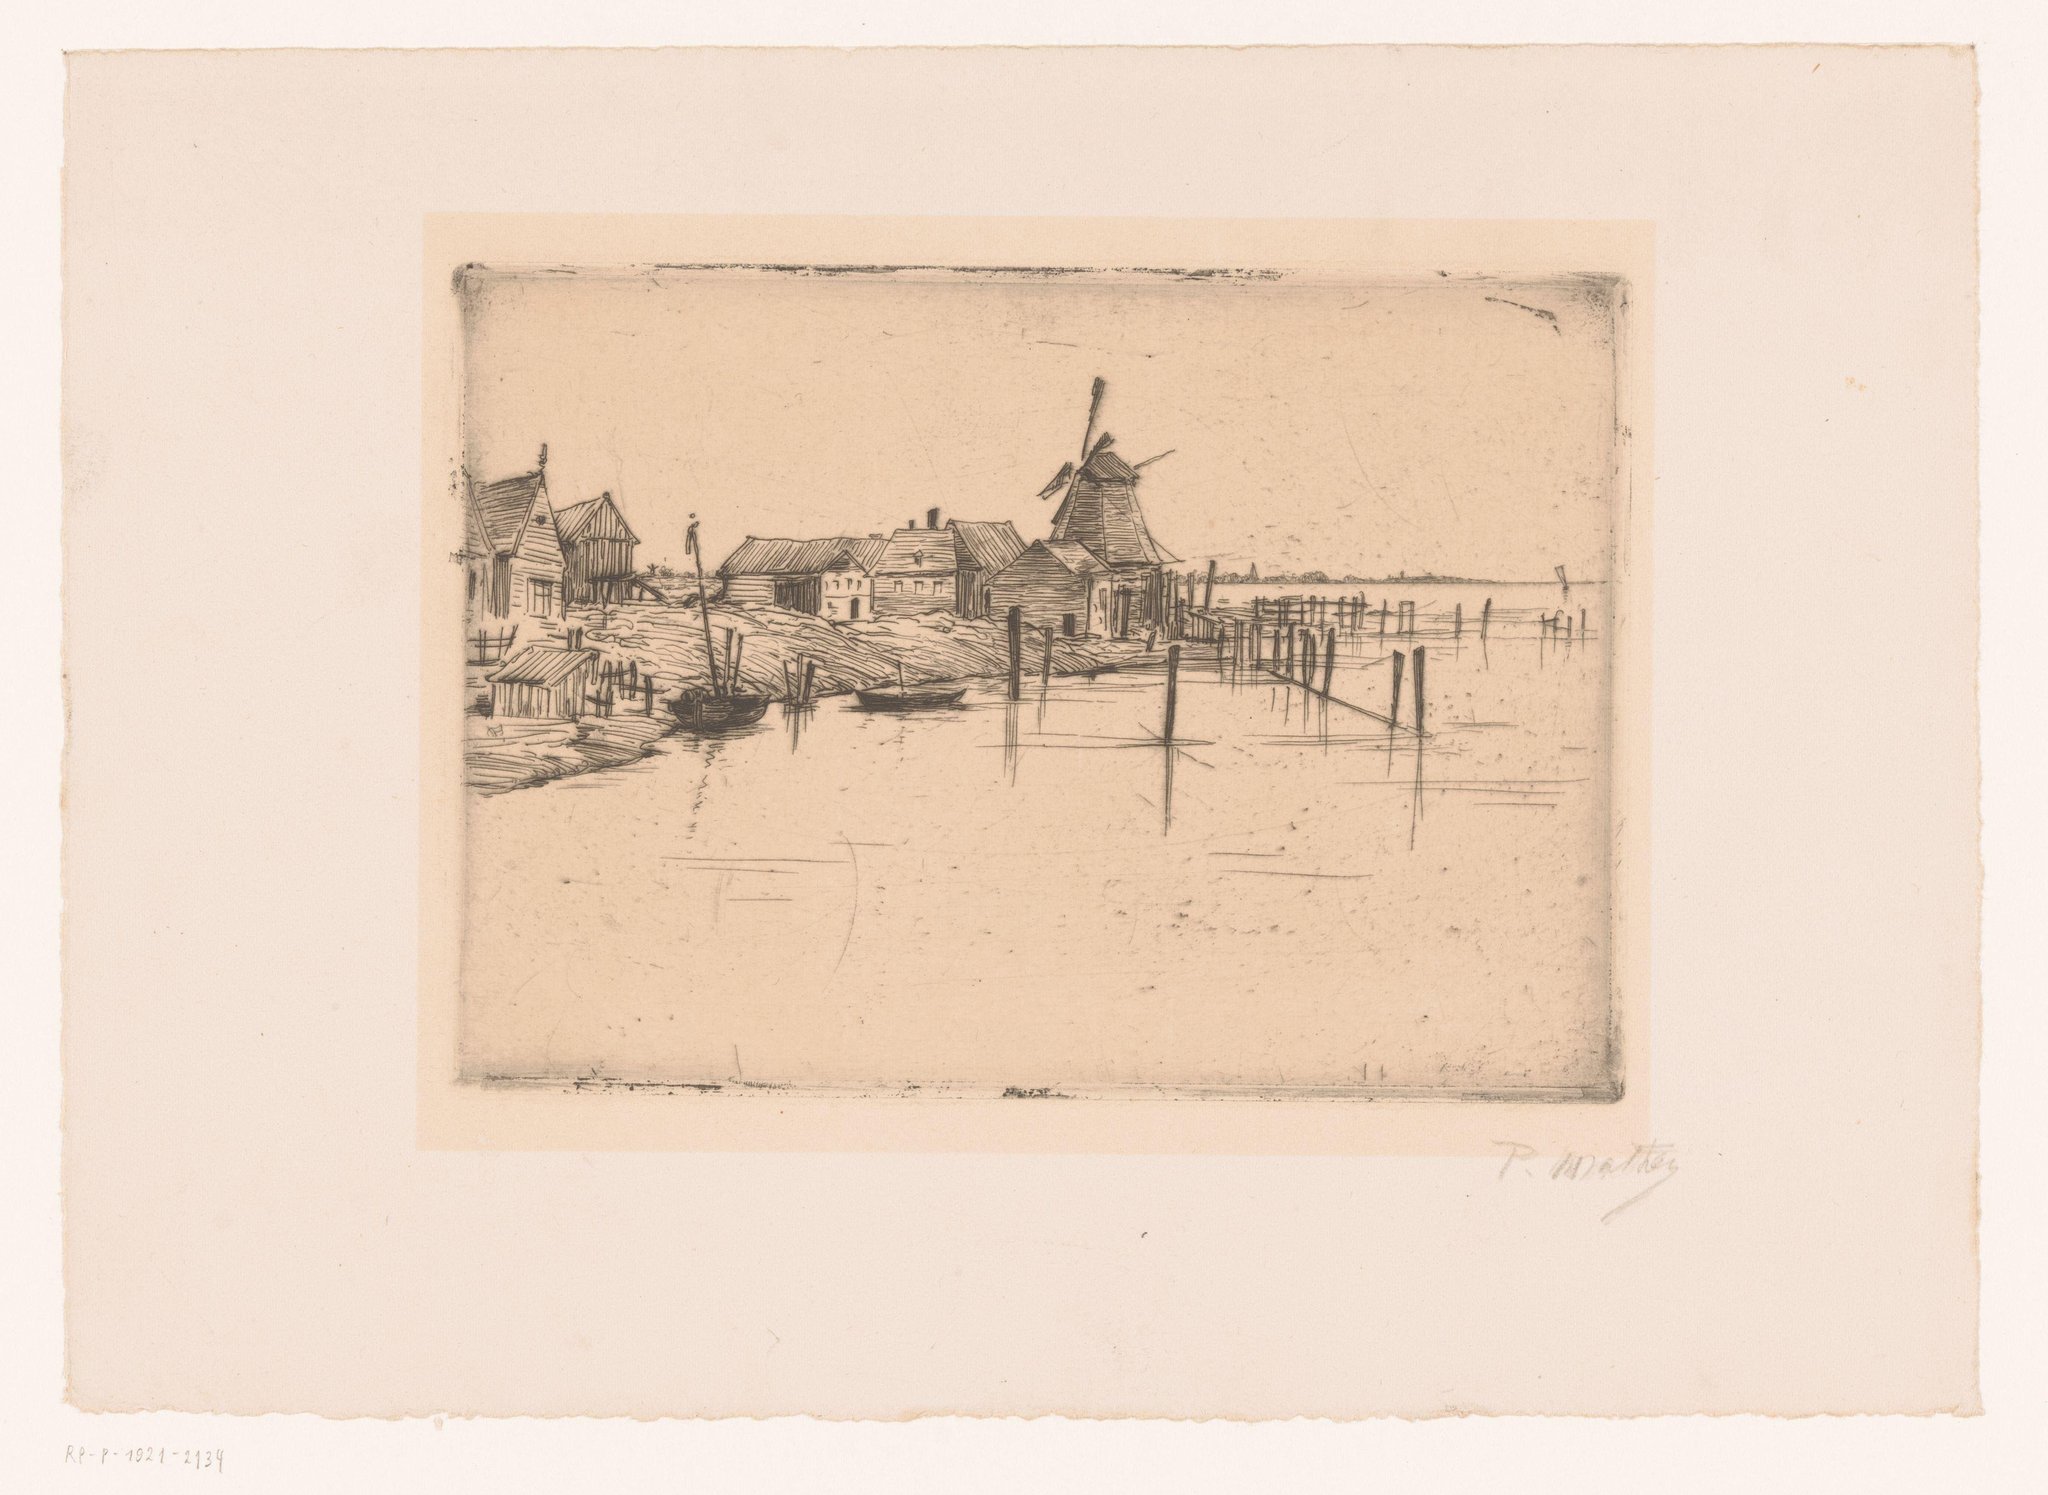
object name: print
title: Landschap met windmolen aan het water, mogelijk Marken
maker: paul mathey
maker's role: print maker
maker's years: 1844-1929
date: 1854-1921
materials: paper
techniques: drypoint, intaglio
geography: france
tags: landscapes with waters, waterscapes, seascapes (in the temperate zone), windmill in landscape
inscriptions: collector's mark: Lugt 2228, watermark